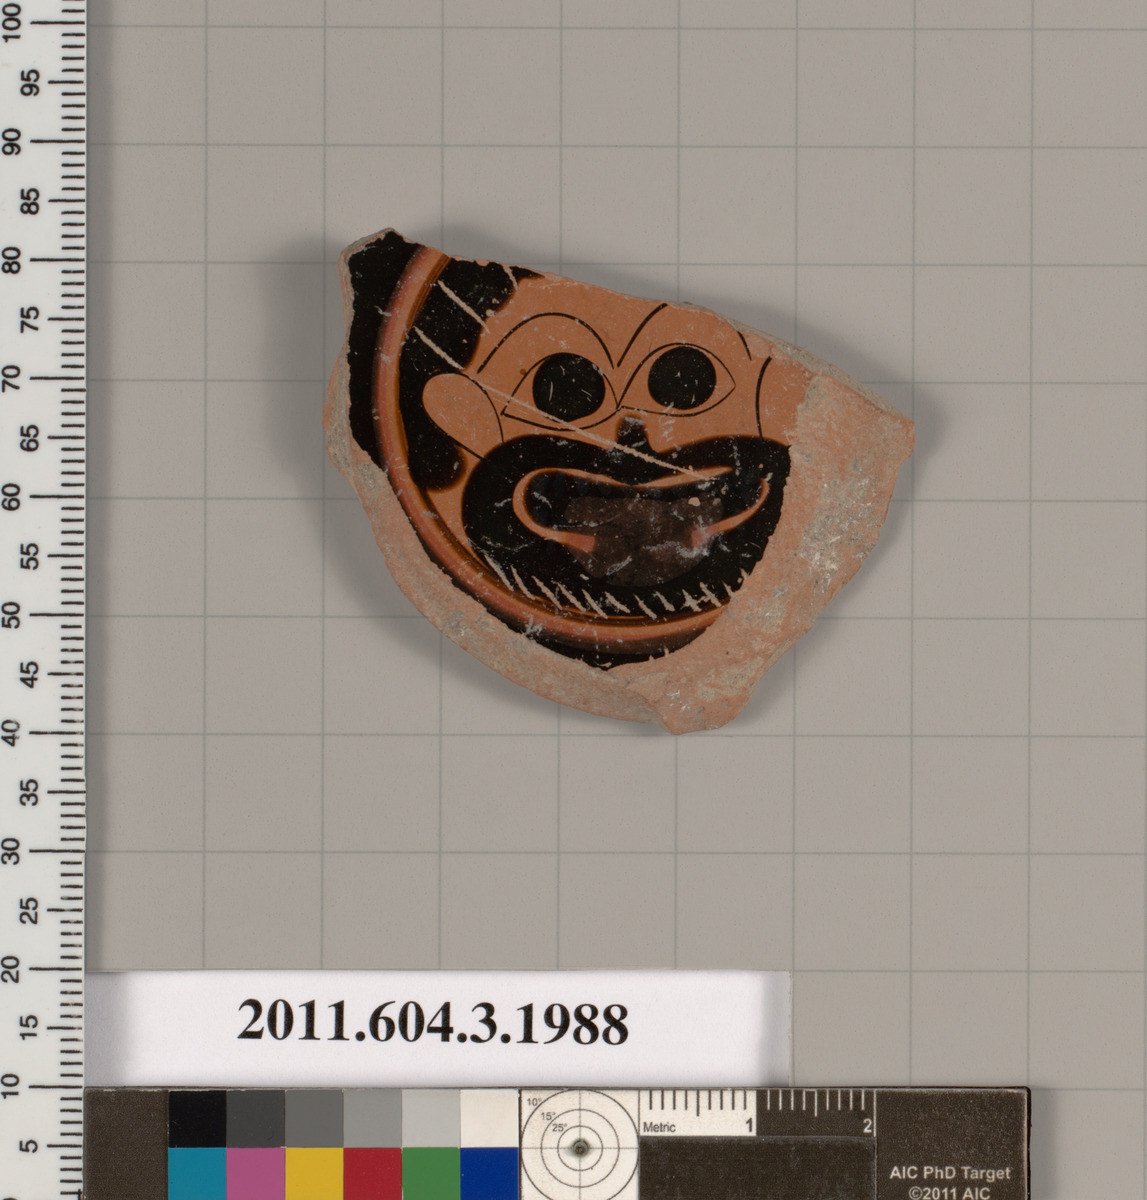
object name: kylix fragment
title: Terracotta fragment of a stemless cup (drinking cup)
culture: greek, attic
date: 550-526 BCE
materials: terracotta